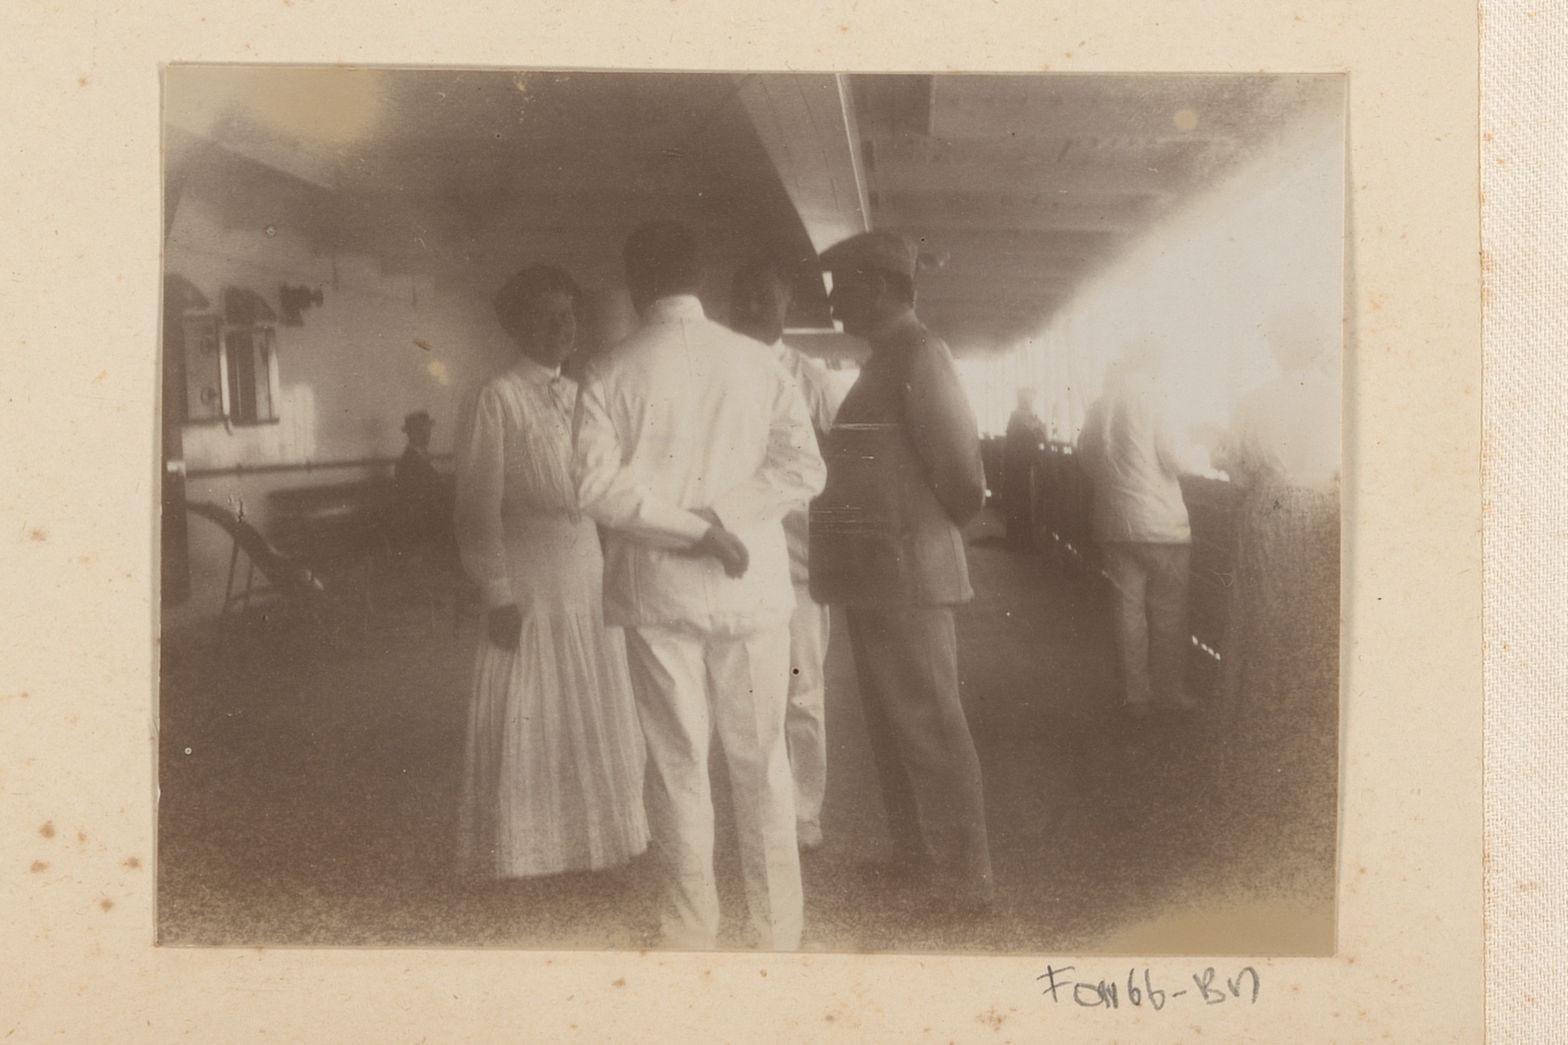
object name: photograph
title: Vrouw en mannen aan dek van een schip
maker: Anonymous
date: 1880-1910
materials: photographic support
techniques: gelatin silver print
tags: adult woman, parts of ship's exterior: deck, adult man, historical persons